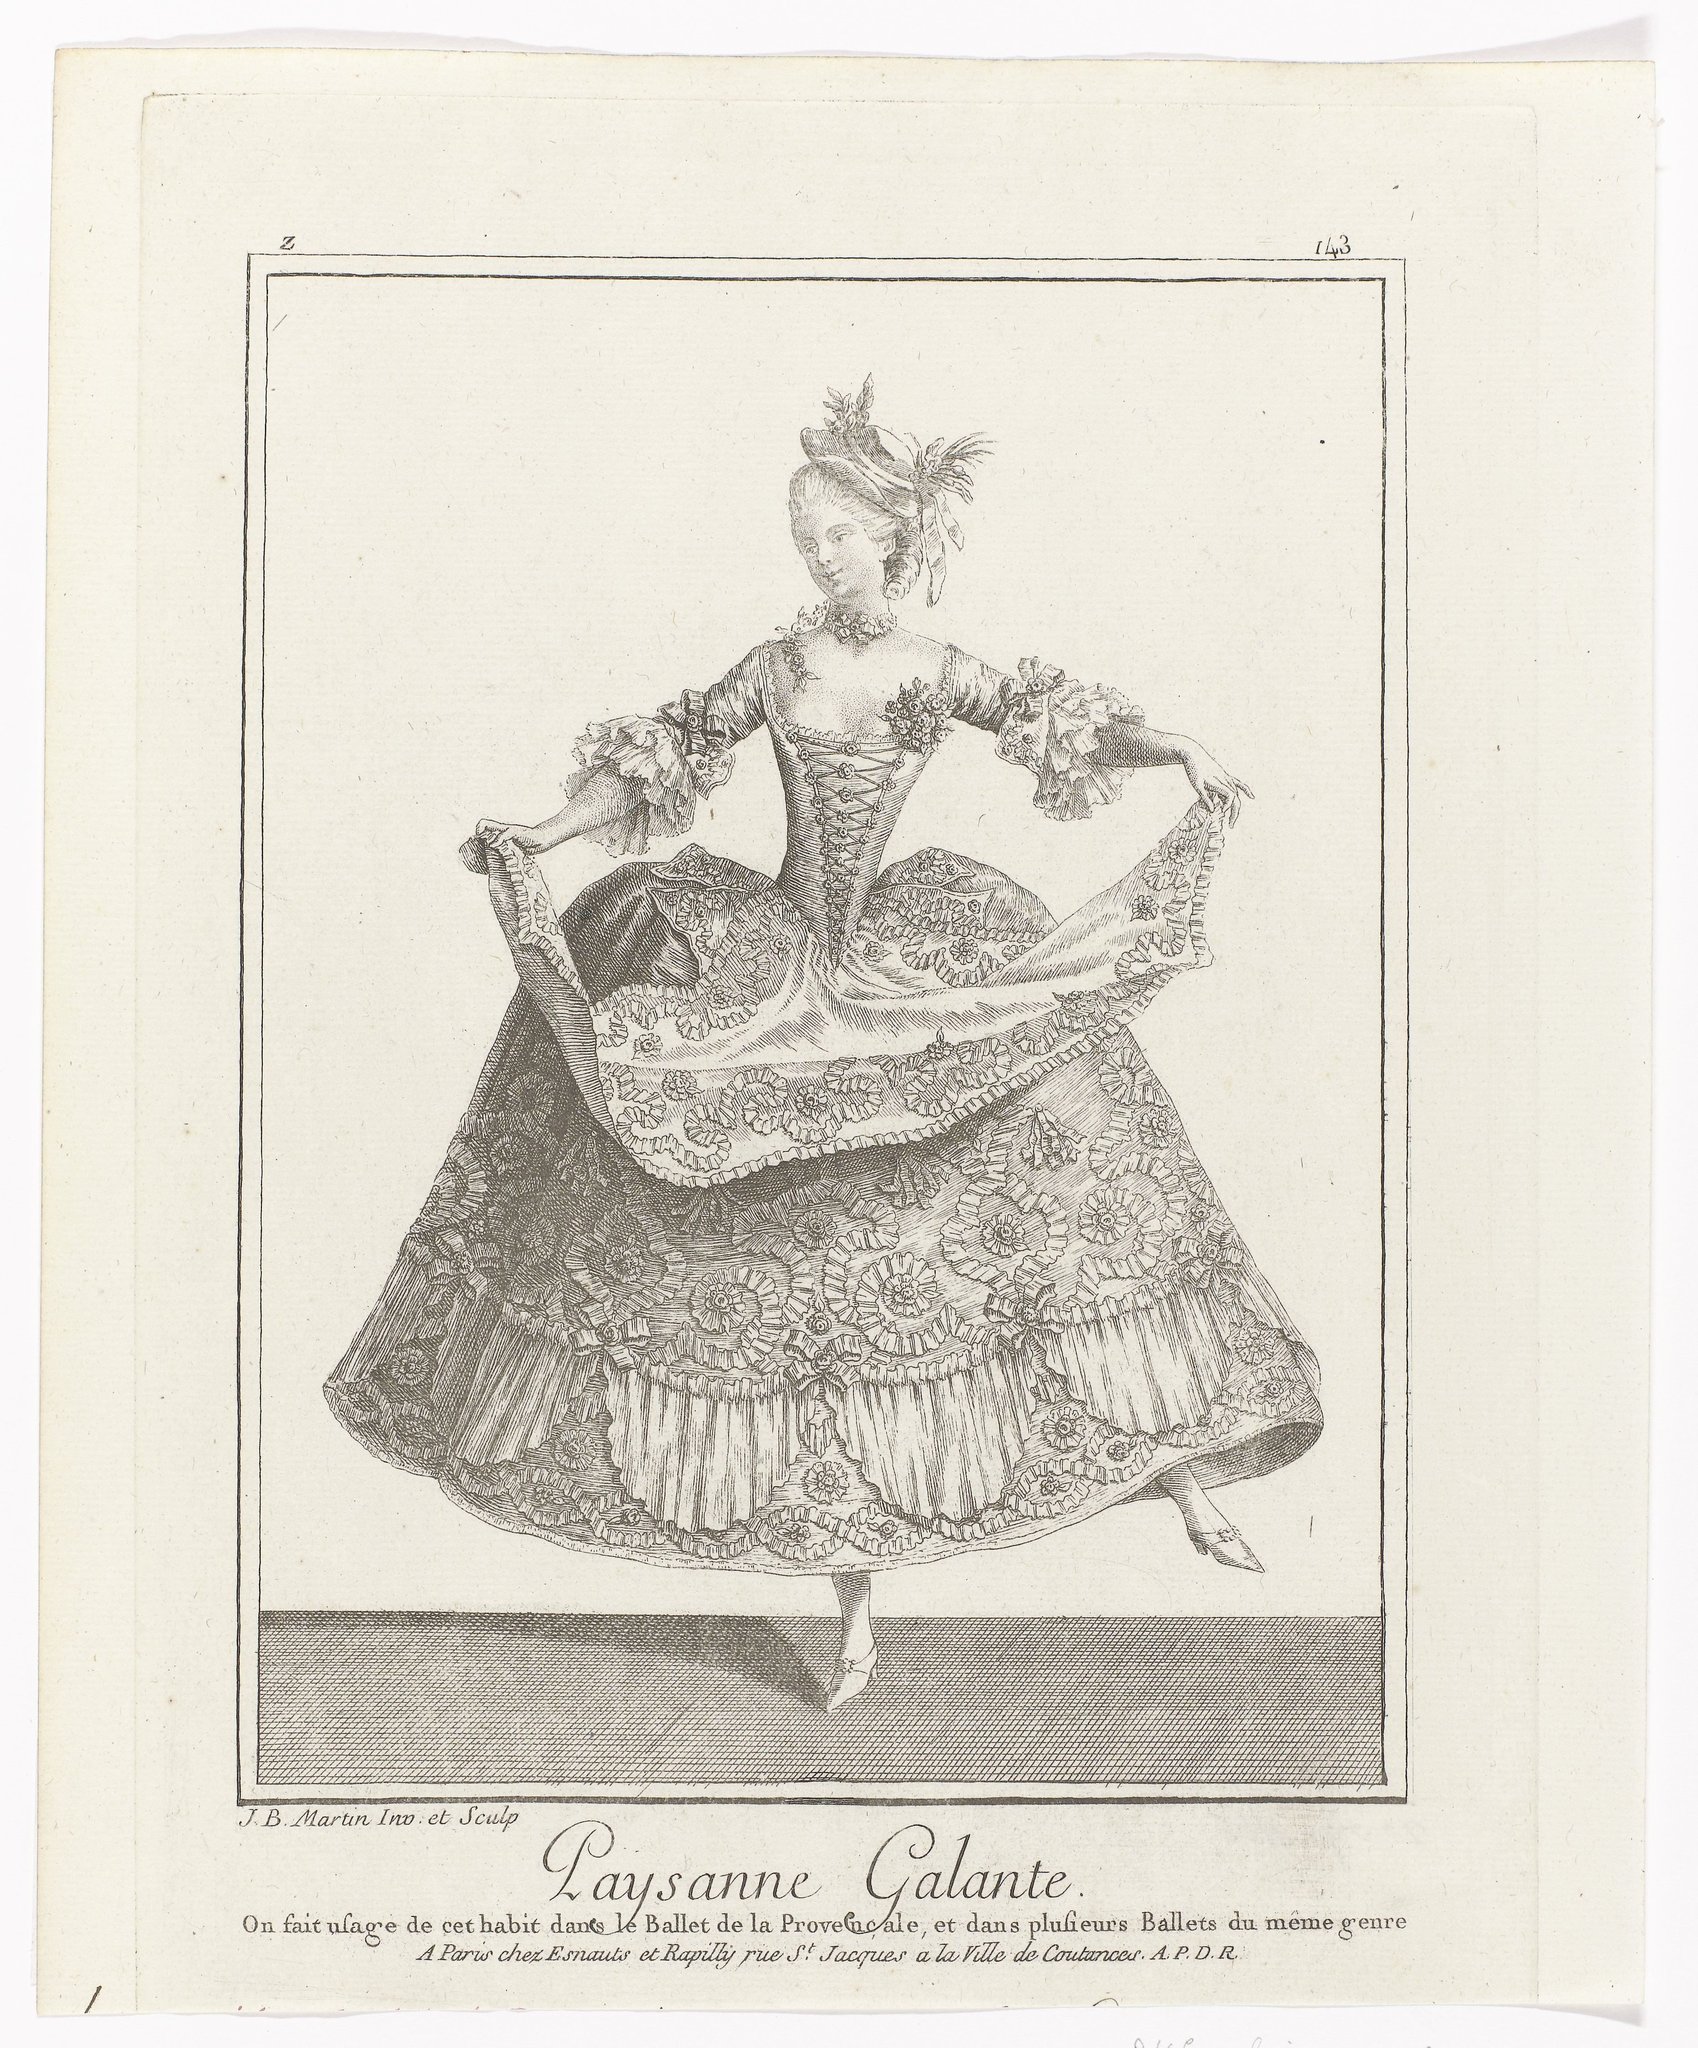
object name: fashion print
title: Gallerie des Modes et Costumes Français, 1779, Z 143 : Paysanne Galante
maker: j.b. martin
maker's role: print maker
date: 1779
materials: paper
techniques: engraving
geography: paris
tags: clothing for the upper part of the body (+ women's clothes), ornamental parts of clothing (+ women's clothes), ballet dress - cc - female, head-gear (+ women's clothes), fashion plates, skirt (+ women's clothes), apron (+ women's clothes), neck-gear ~ clothing (+ women's clothes)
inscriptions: caption: ‘On fait usage de cet habit dans le Ballet de la Provinçale, et dans plusieurs Ballets du même genre.’, address: ‘A Paris chez Esnauts et Rapilly, rue St. Jacques a la Ville de Coutances. A.P.D.R.’, title: ‘Paysanne Galante’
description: Danseres in balletkostuum van een elegante boerin. Zij draagt een japon met puntig korset en vierkante halsuitsnijding, driekwart mouwen met strikken en engageantes. De rok en het sierschort zijn versierd met rozetten en strikken. Schuin op het hoofd een klein hoedje met lint en bloemen. Om de hals een gerimpeld lint met strik. Schoenen met hak en gesp. Prent uit serie Z. 24e Cahier de Costumes Français, 18e Suite d'Habillemens à la mode en 1779, Gallerie des Modes et Costumes Français.